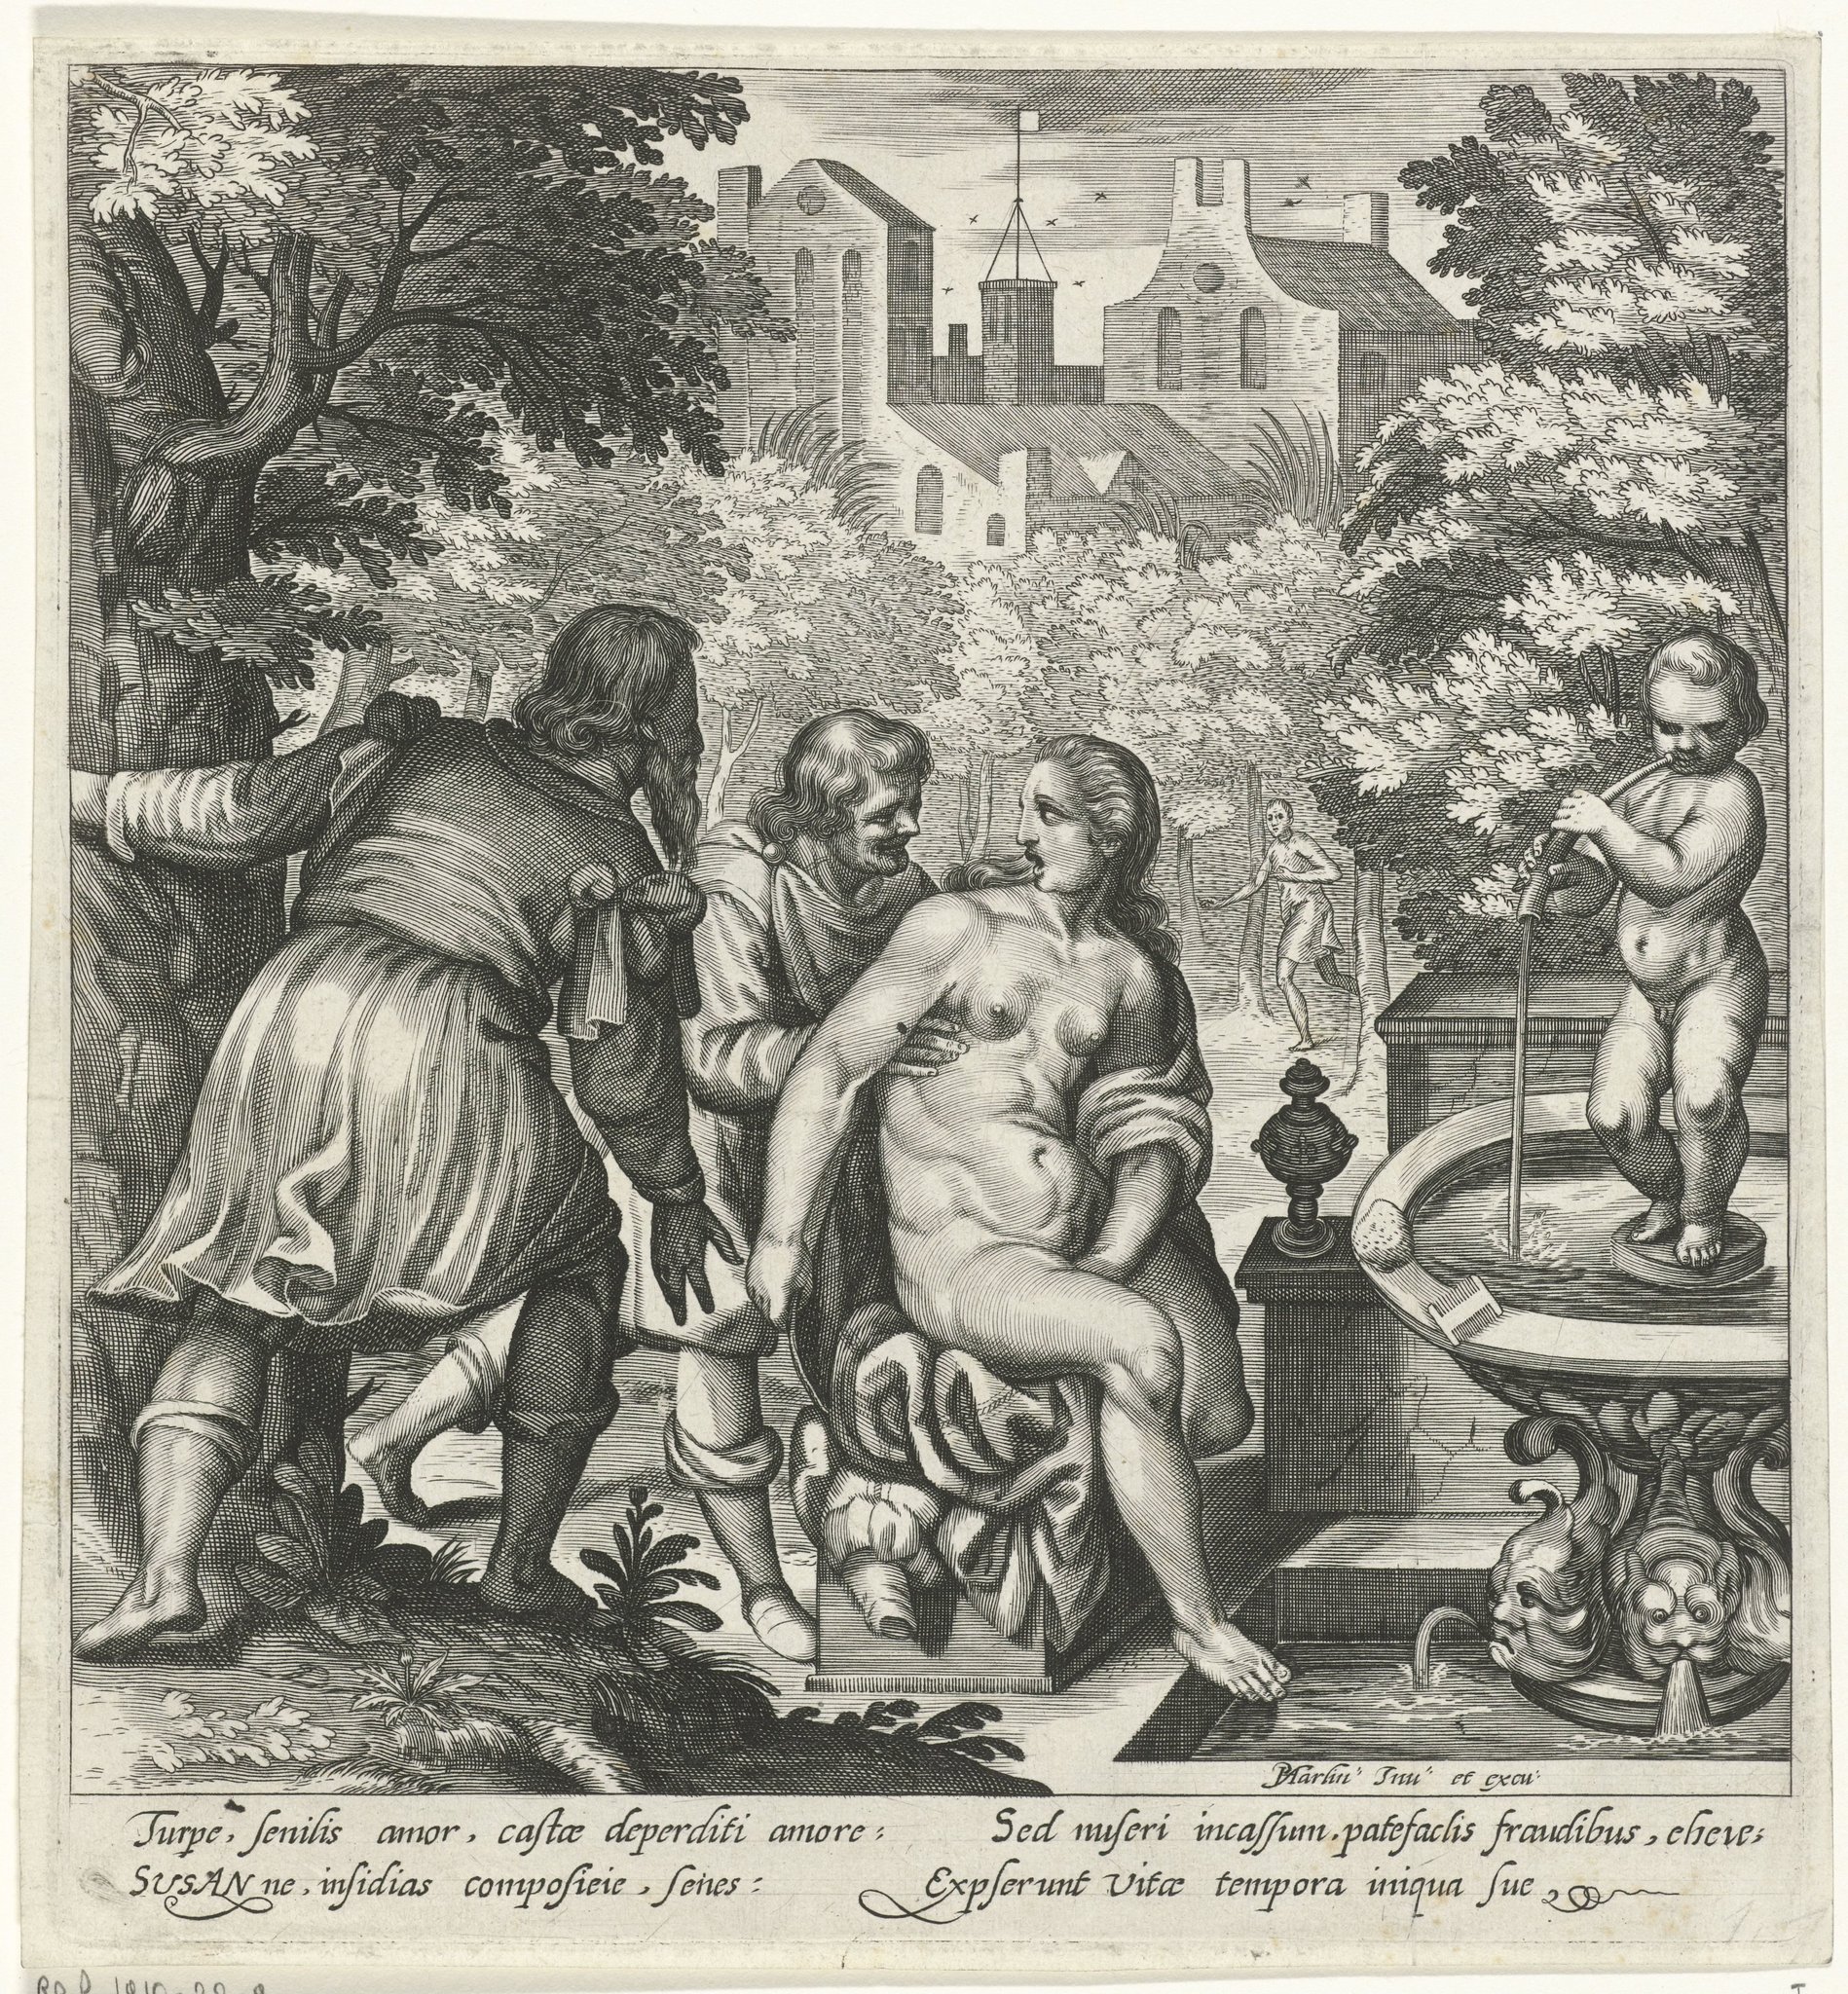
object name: print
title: Susanna en de ouderlingen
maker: pieter feddes van harlingen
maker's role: painter, print maker, publisher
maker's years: 1586-1623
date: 1596-1623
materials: paper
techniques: engraving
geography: harlingen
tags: the elders making advances towards susanna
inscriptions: collector's mark: Lugt 2228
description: Susanna bij een fontein. Zij wordt bij het baden door twee ouderlingen belaagd en probeert hen tegen te houden. De prent heeft een Latijns onderschrift.